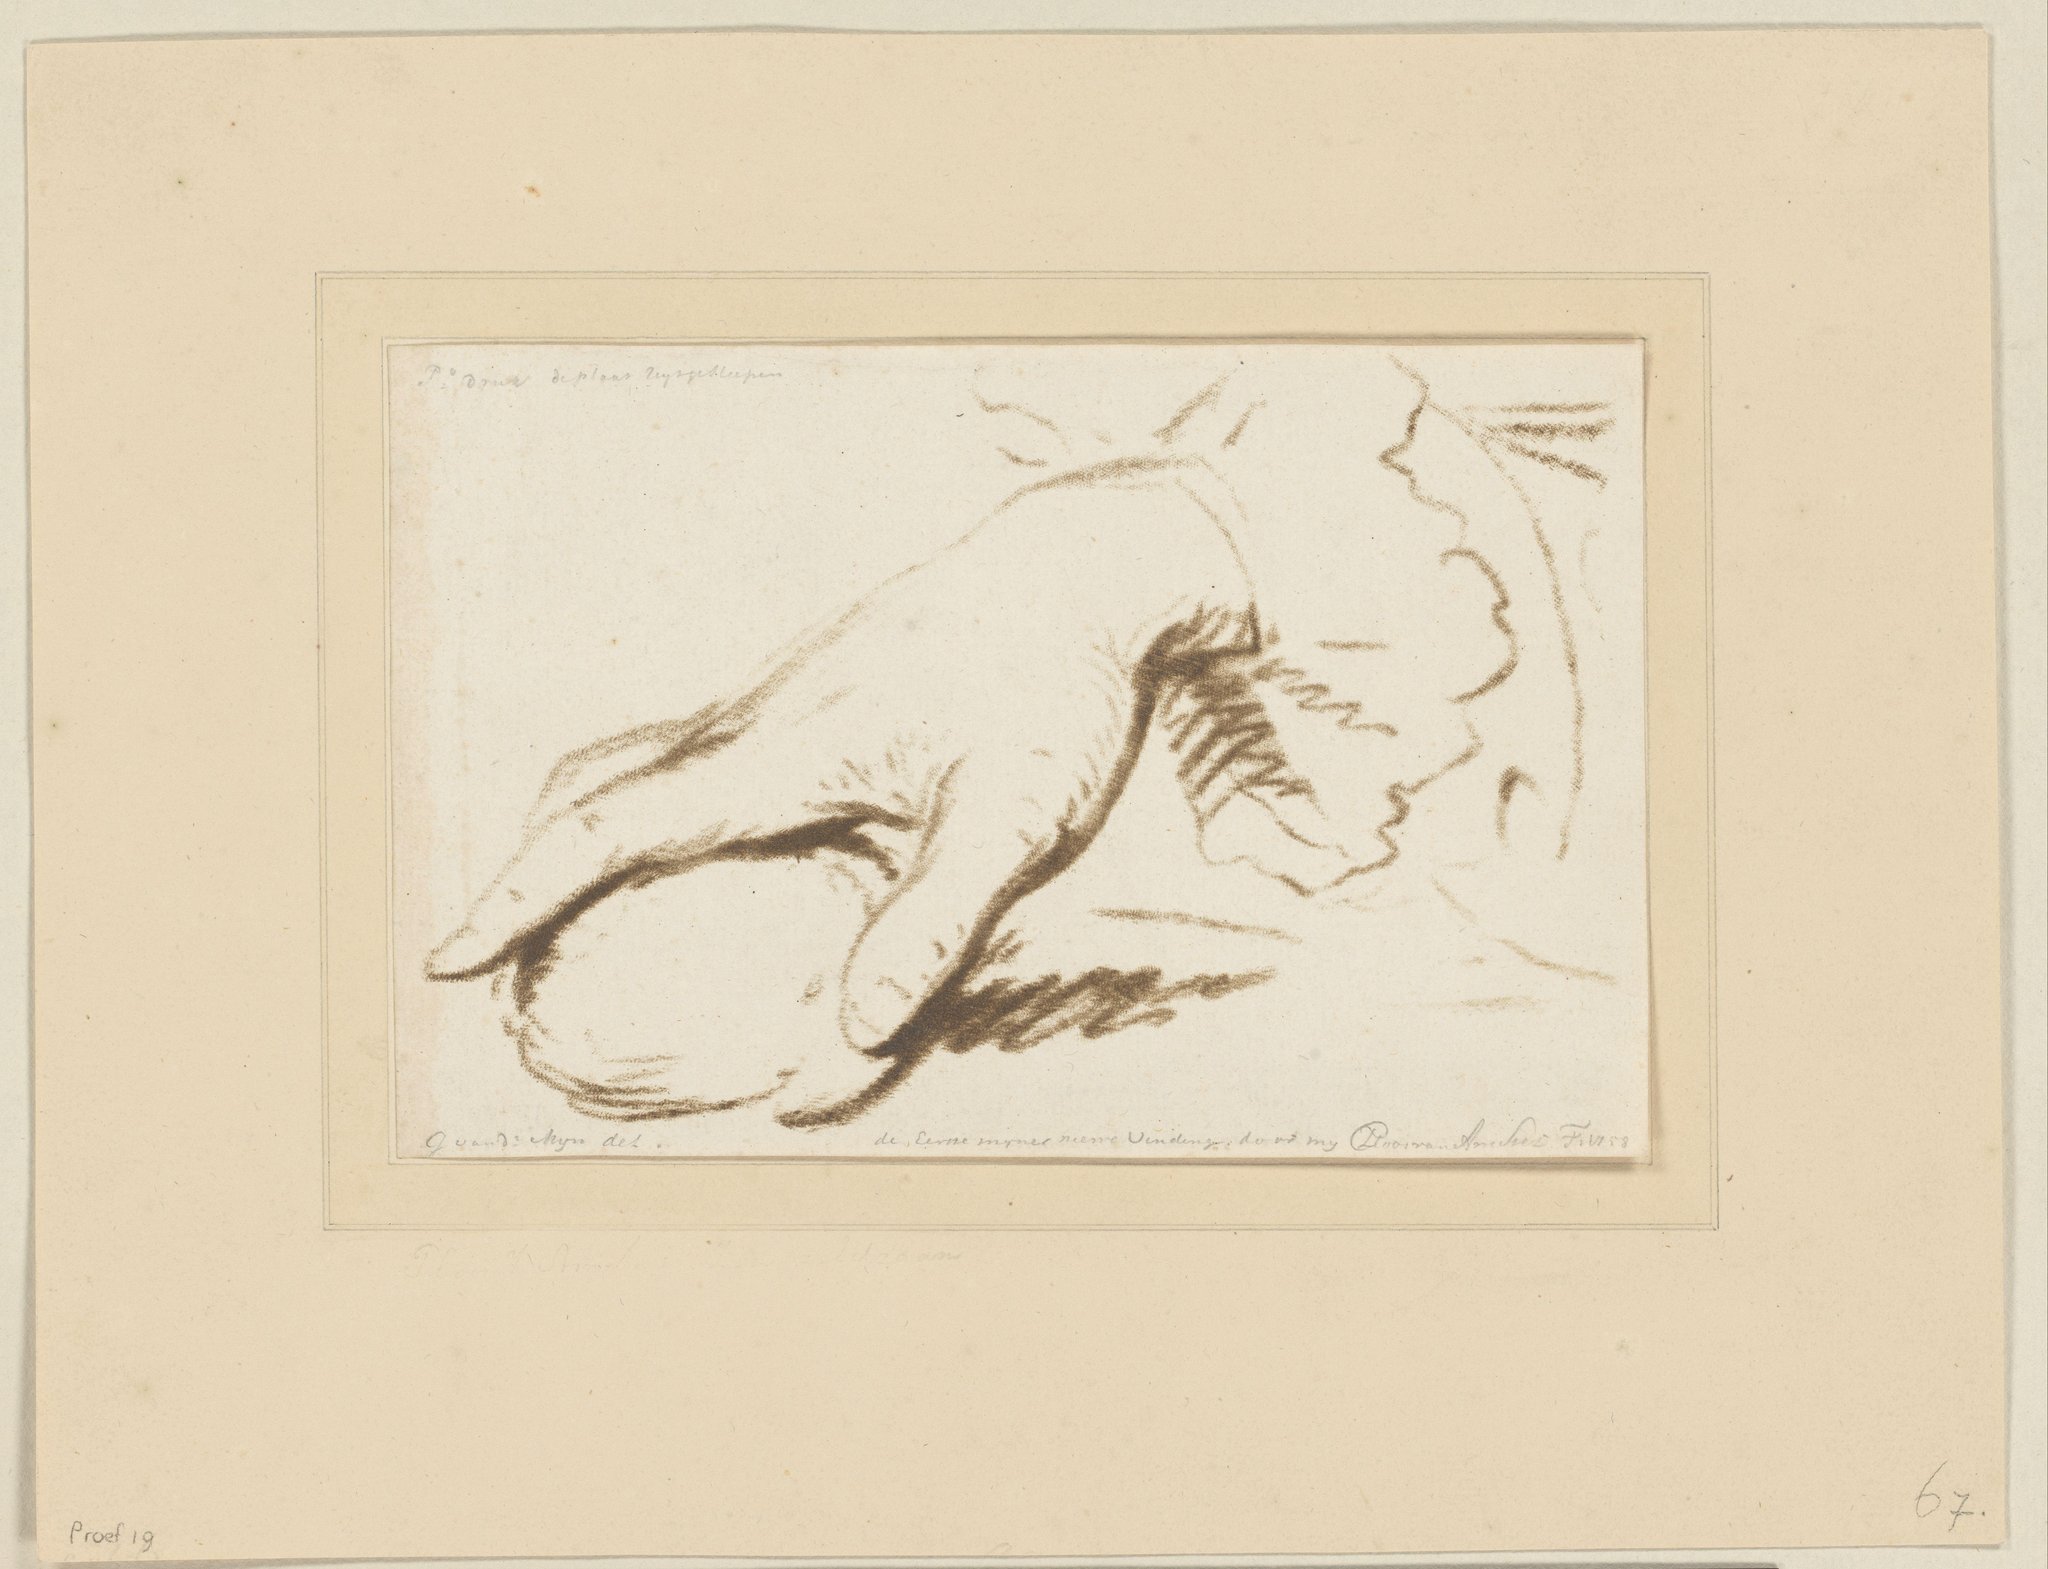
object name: print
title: Studie van een hand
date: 1758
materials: paper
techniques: printmaking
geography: amsterdam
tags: hand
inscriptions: inscription: ‘Geoffreerd aan myne waerde Vriend den Heere Metayer, zoon van dHeer Philipus Metayer/ nu noemende de zyne Ed. Ootm. dienaer de vriend CPloos v Amstel/ dit is de eerste die naar mijn vinding geslaagt is, en de heer Ph. Metayer overtuigt heeft, dit niet door Ponsoenyser te doen was’, inscription: ‘P. druk de plaat uytgesleepen/ G vande Myn del./ de Eerste mijner nieuwe vinding door mij Ploos van Amstel F. 1758.’, collector's mark: Lugt 2760